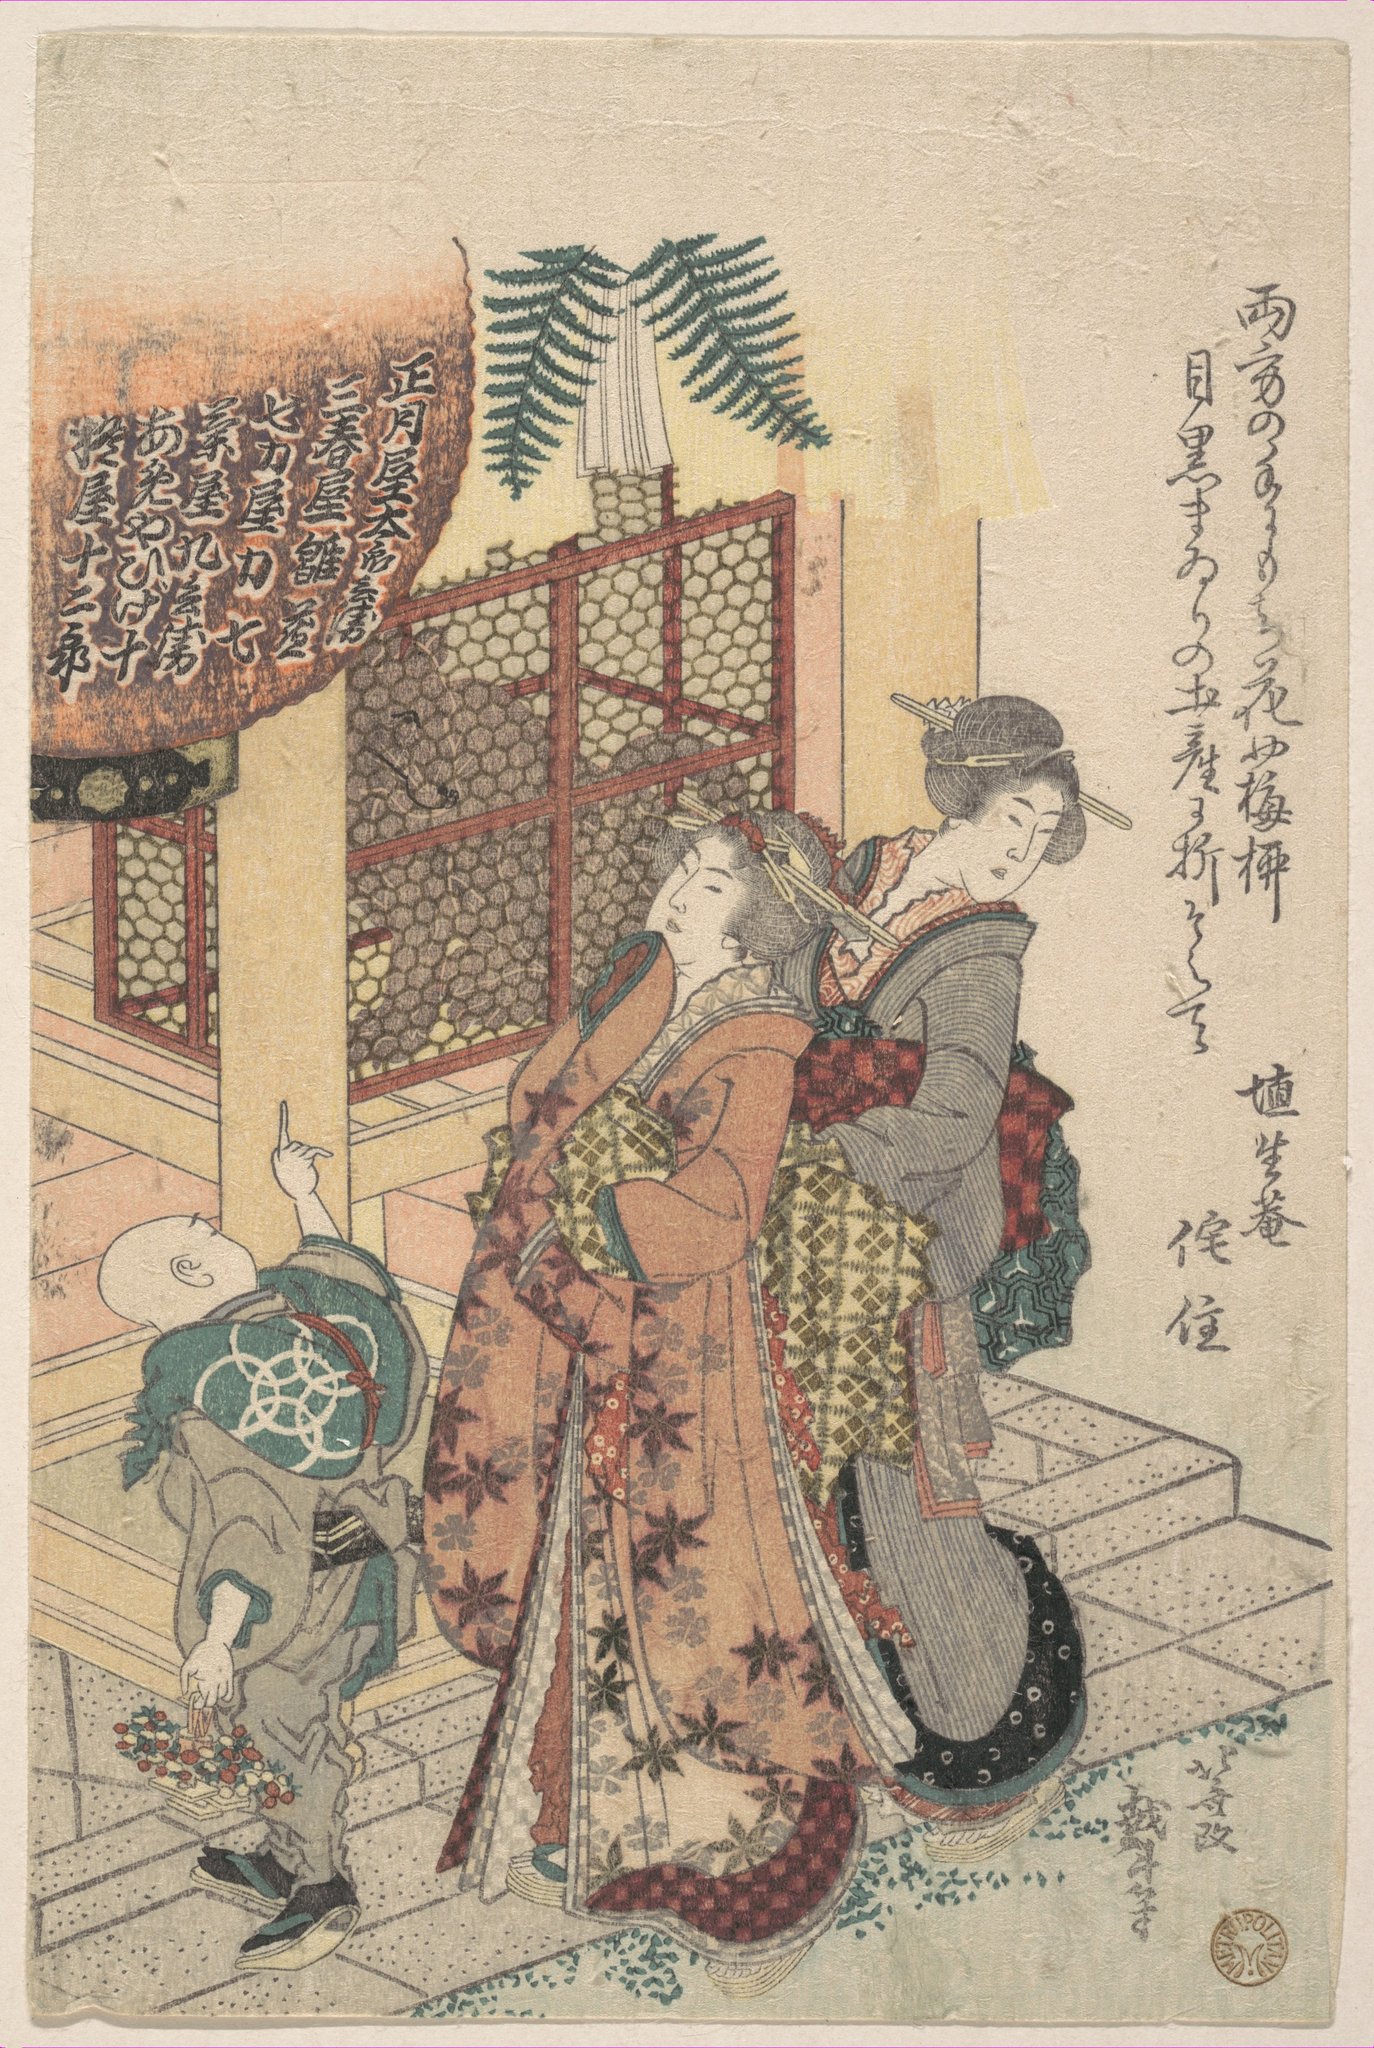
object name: print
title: Young Ladies Paying Homage to a Shrine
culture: japanese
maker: katsushika hokusai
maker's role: artist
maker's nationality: japanese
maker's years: 1760-1849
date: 1814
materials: ink, paper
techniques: surimono, woodblock print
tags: boys,women